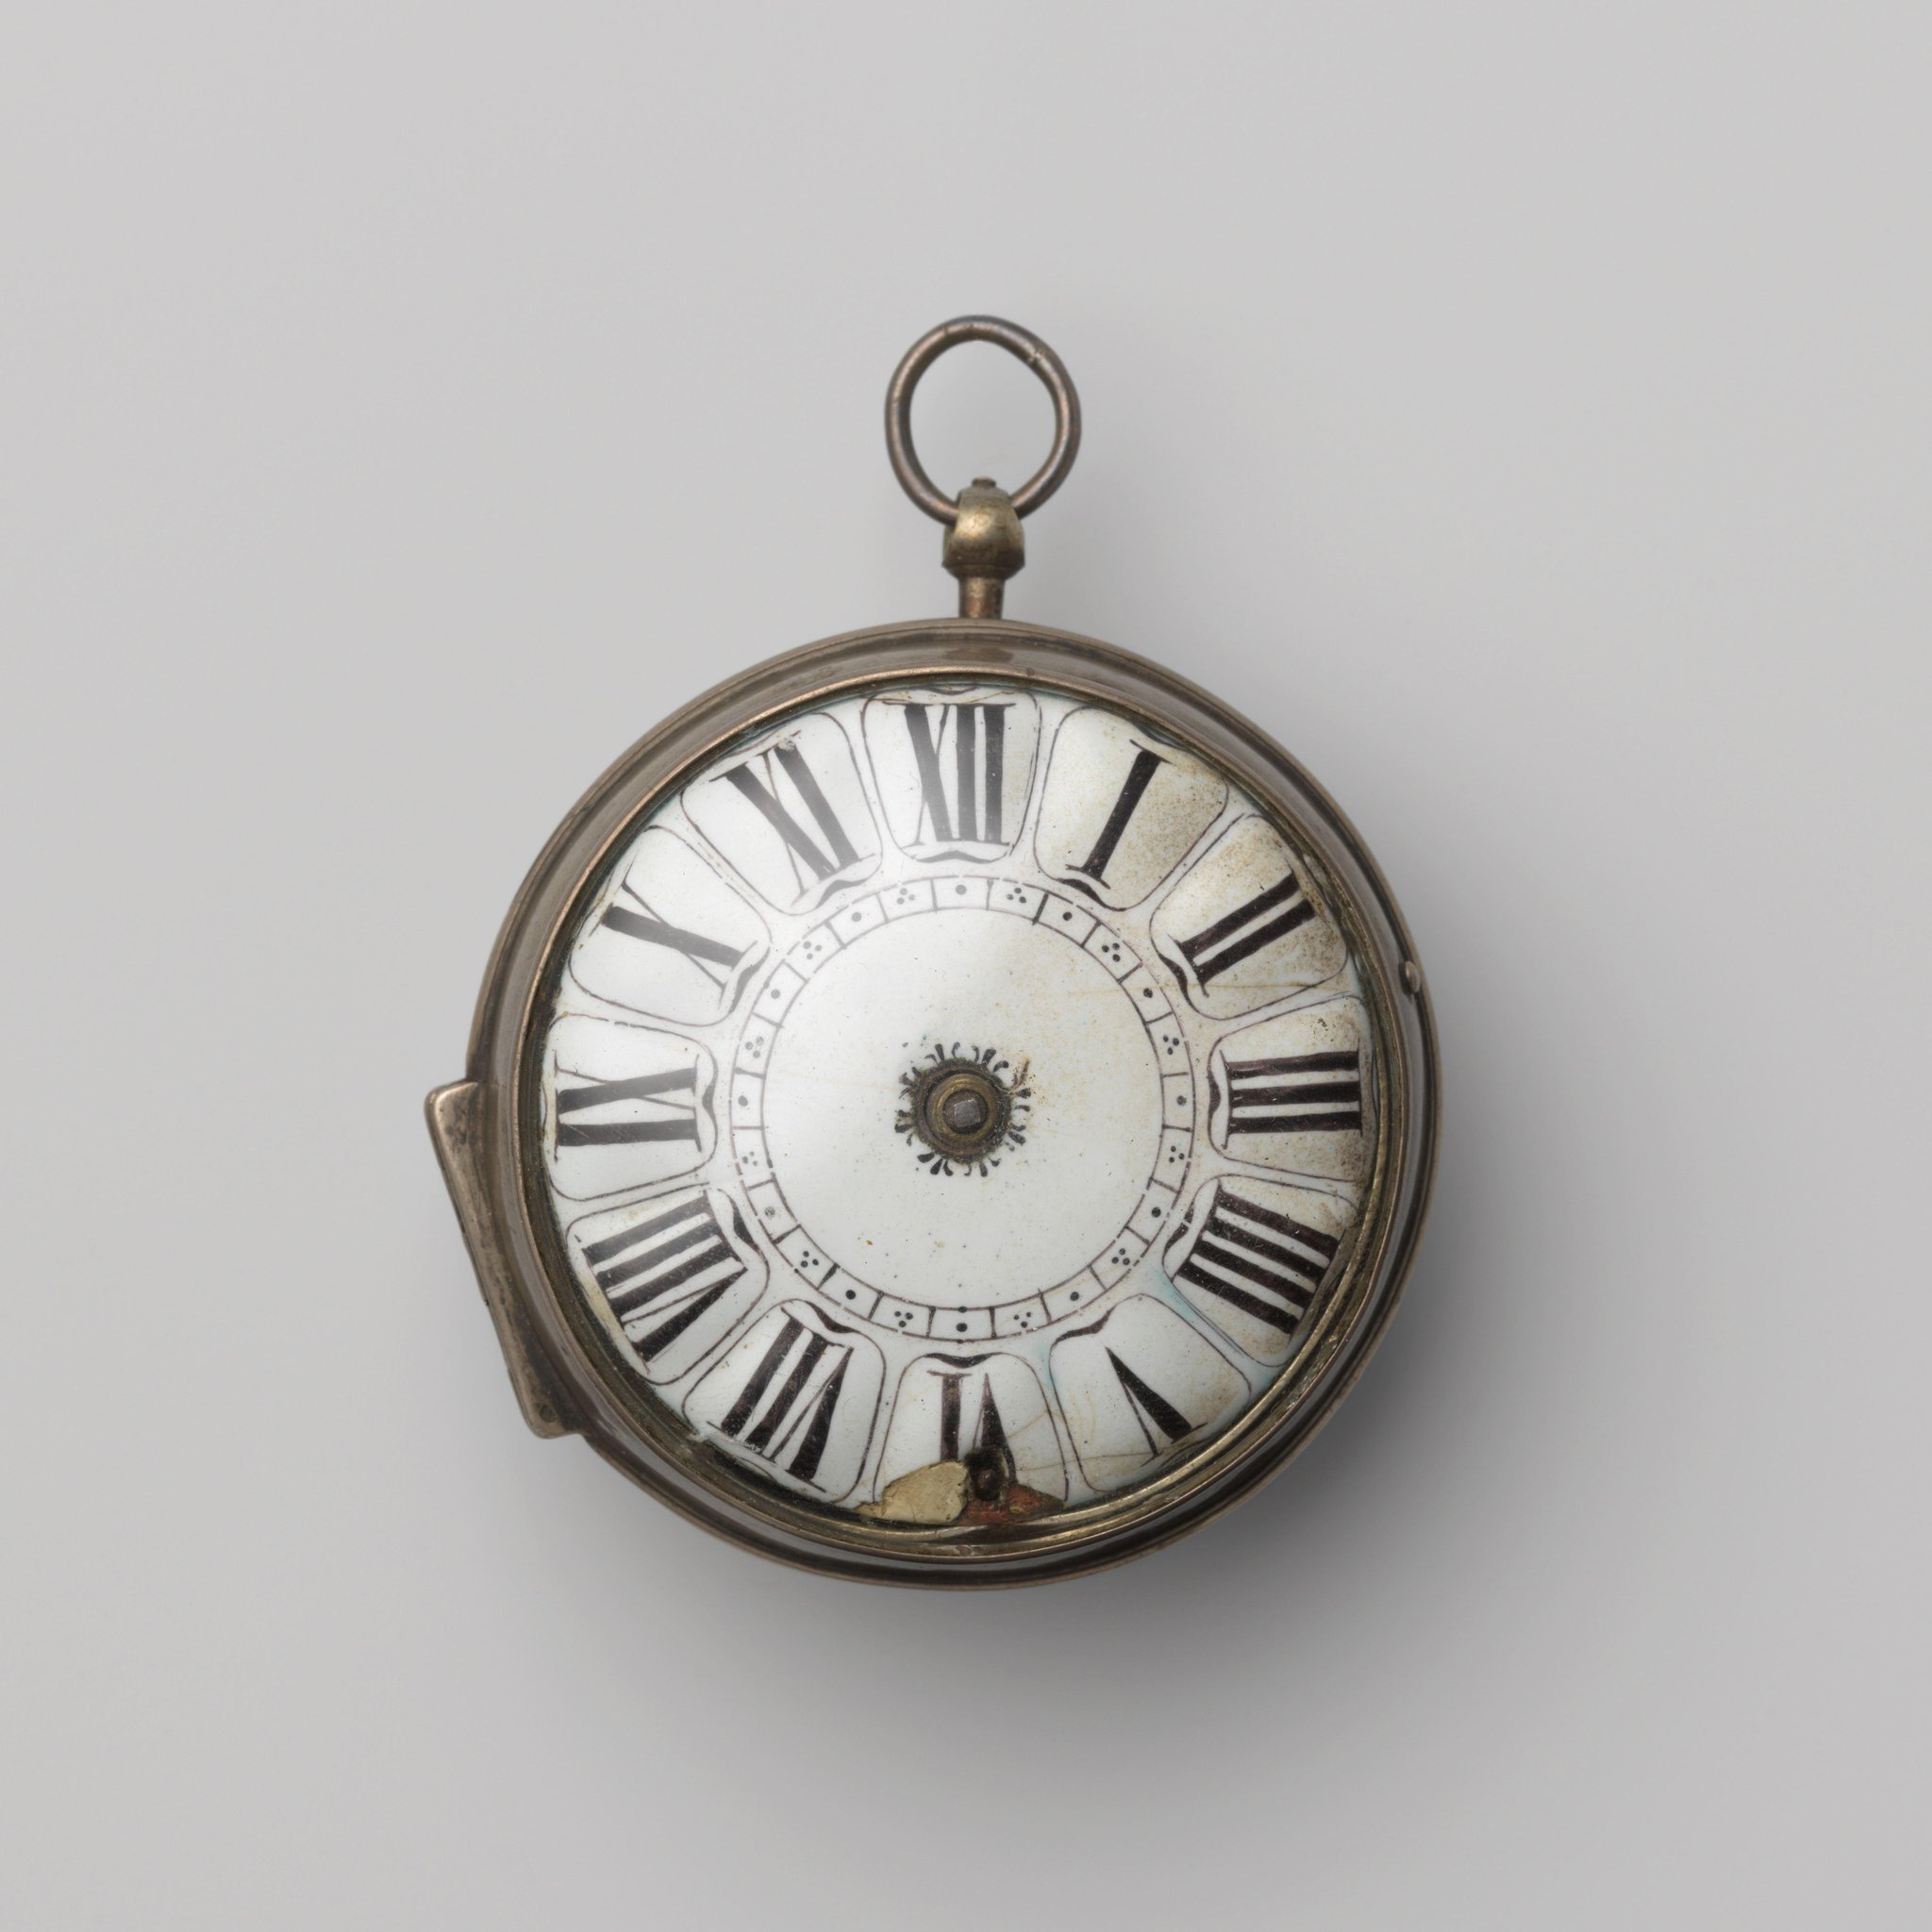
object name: jewellery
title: Herenhorloge van zilver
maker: jean carré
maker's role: clockmaker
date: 1680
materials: silver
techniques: enameling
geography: france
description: Herenhorloge van zilver met wit geëmailleerde wijzerplaat. Op de achterbodem enige concentrische cirkels.